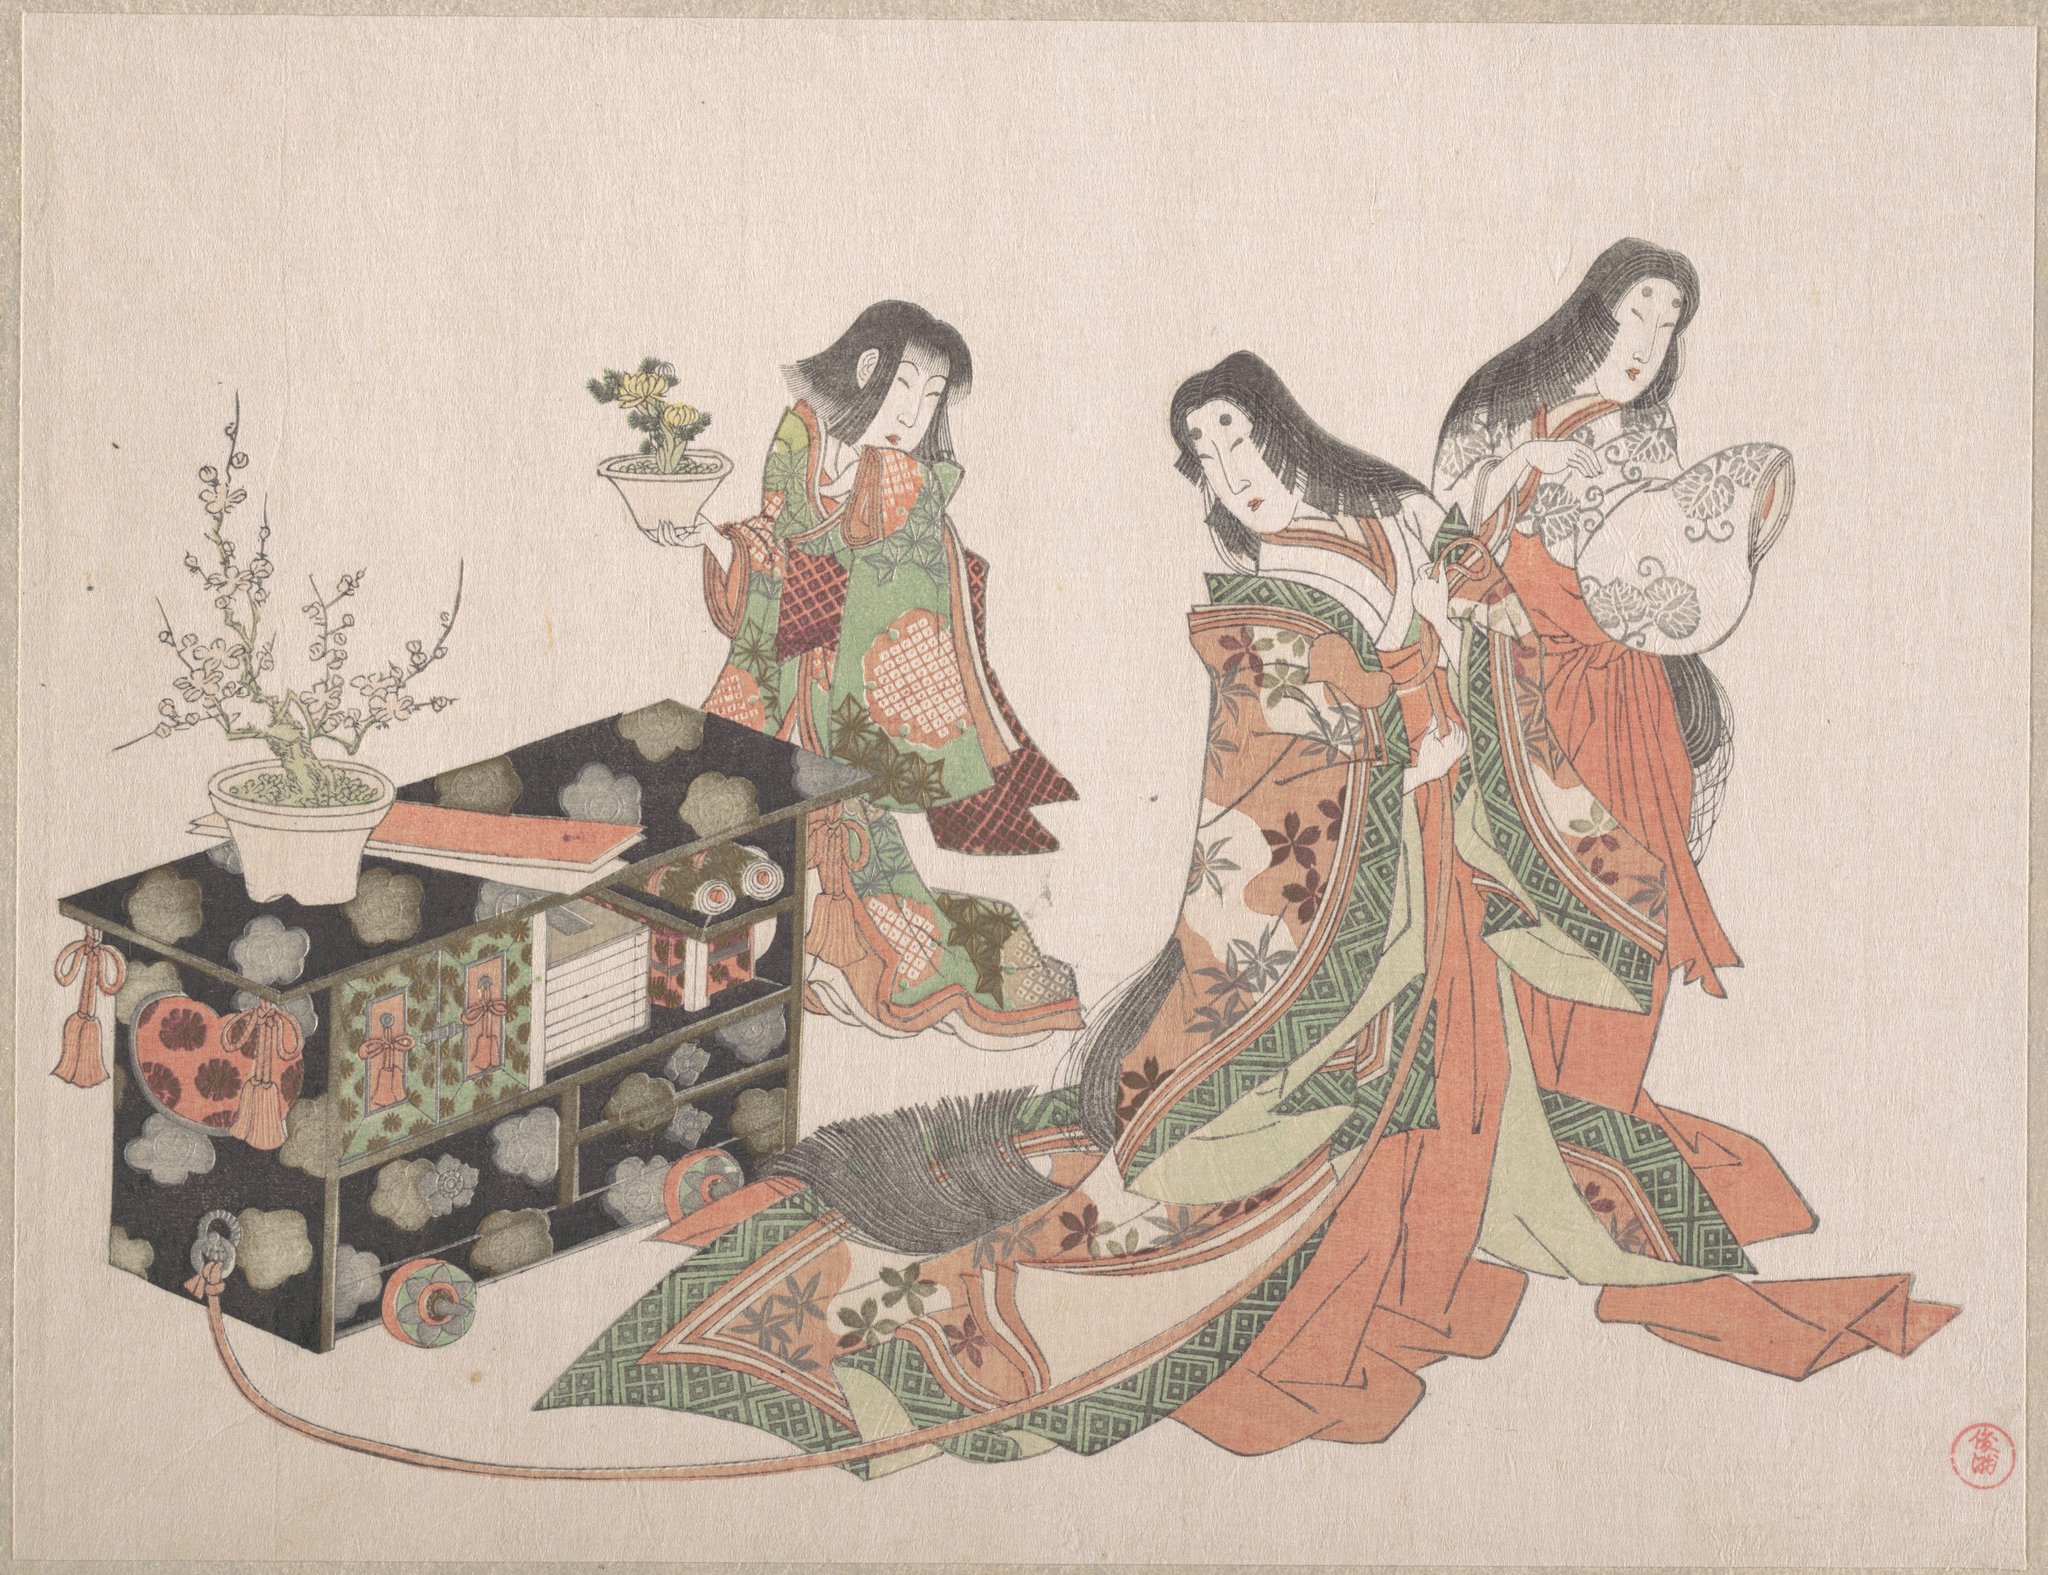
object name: print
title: Court Ladies Dragging a Cabinet along the Floor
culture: japanese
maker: kubo shunman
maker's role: artist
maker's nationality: japanese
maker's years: 1757-1820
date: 1801-1900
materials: ink, paper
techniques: surimono, woodblock print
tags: women,plants,cabinets